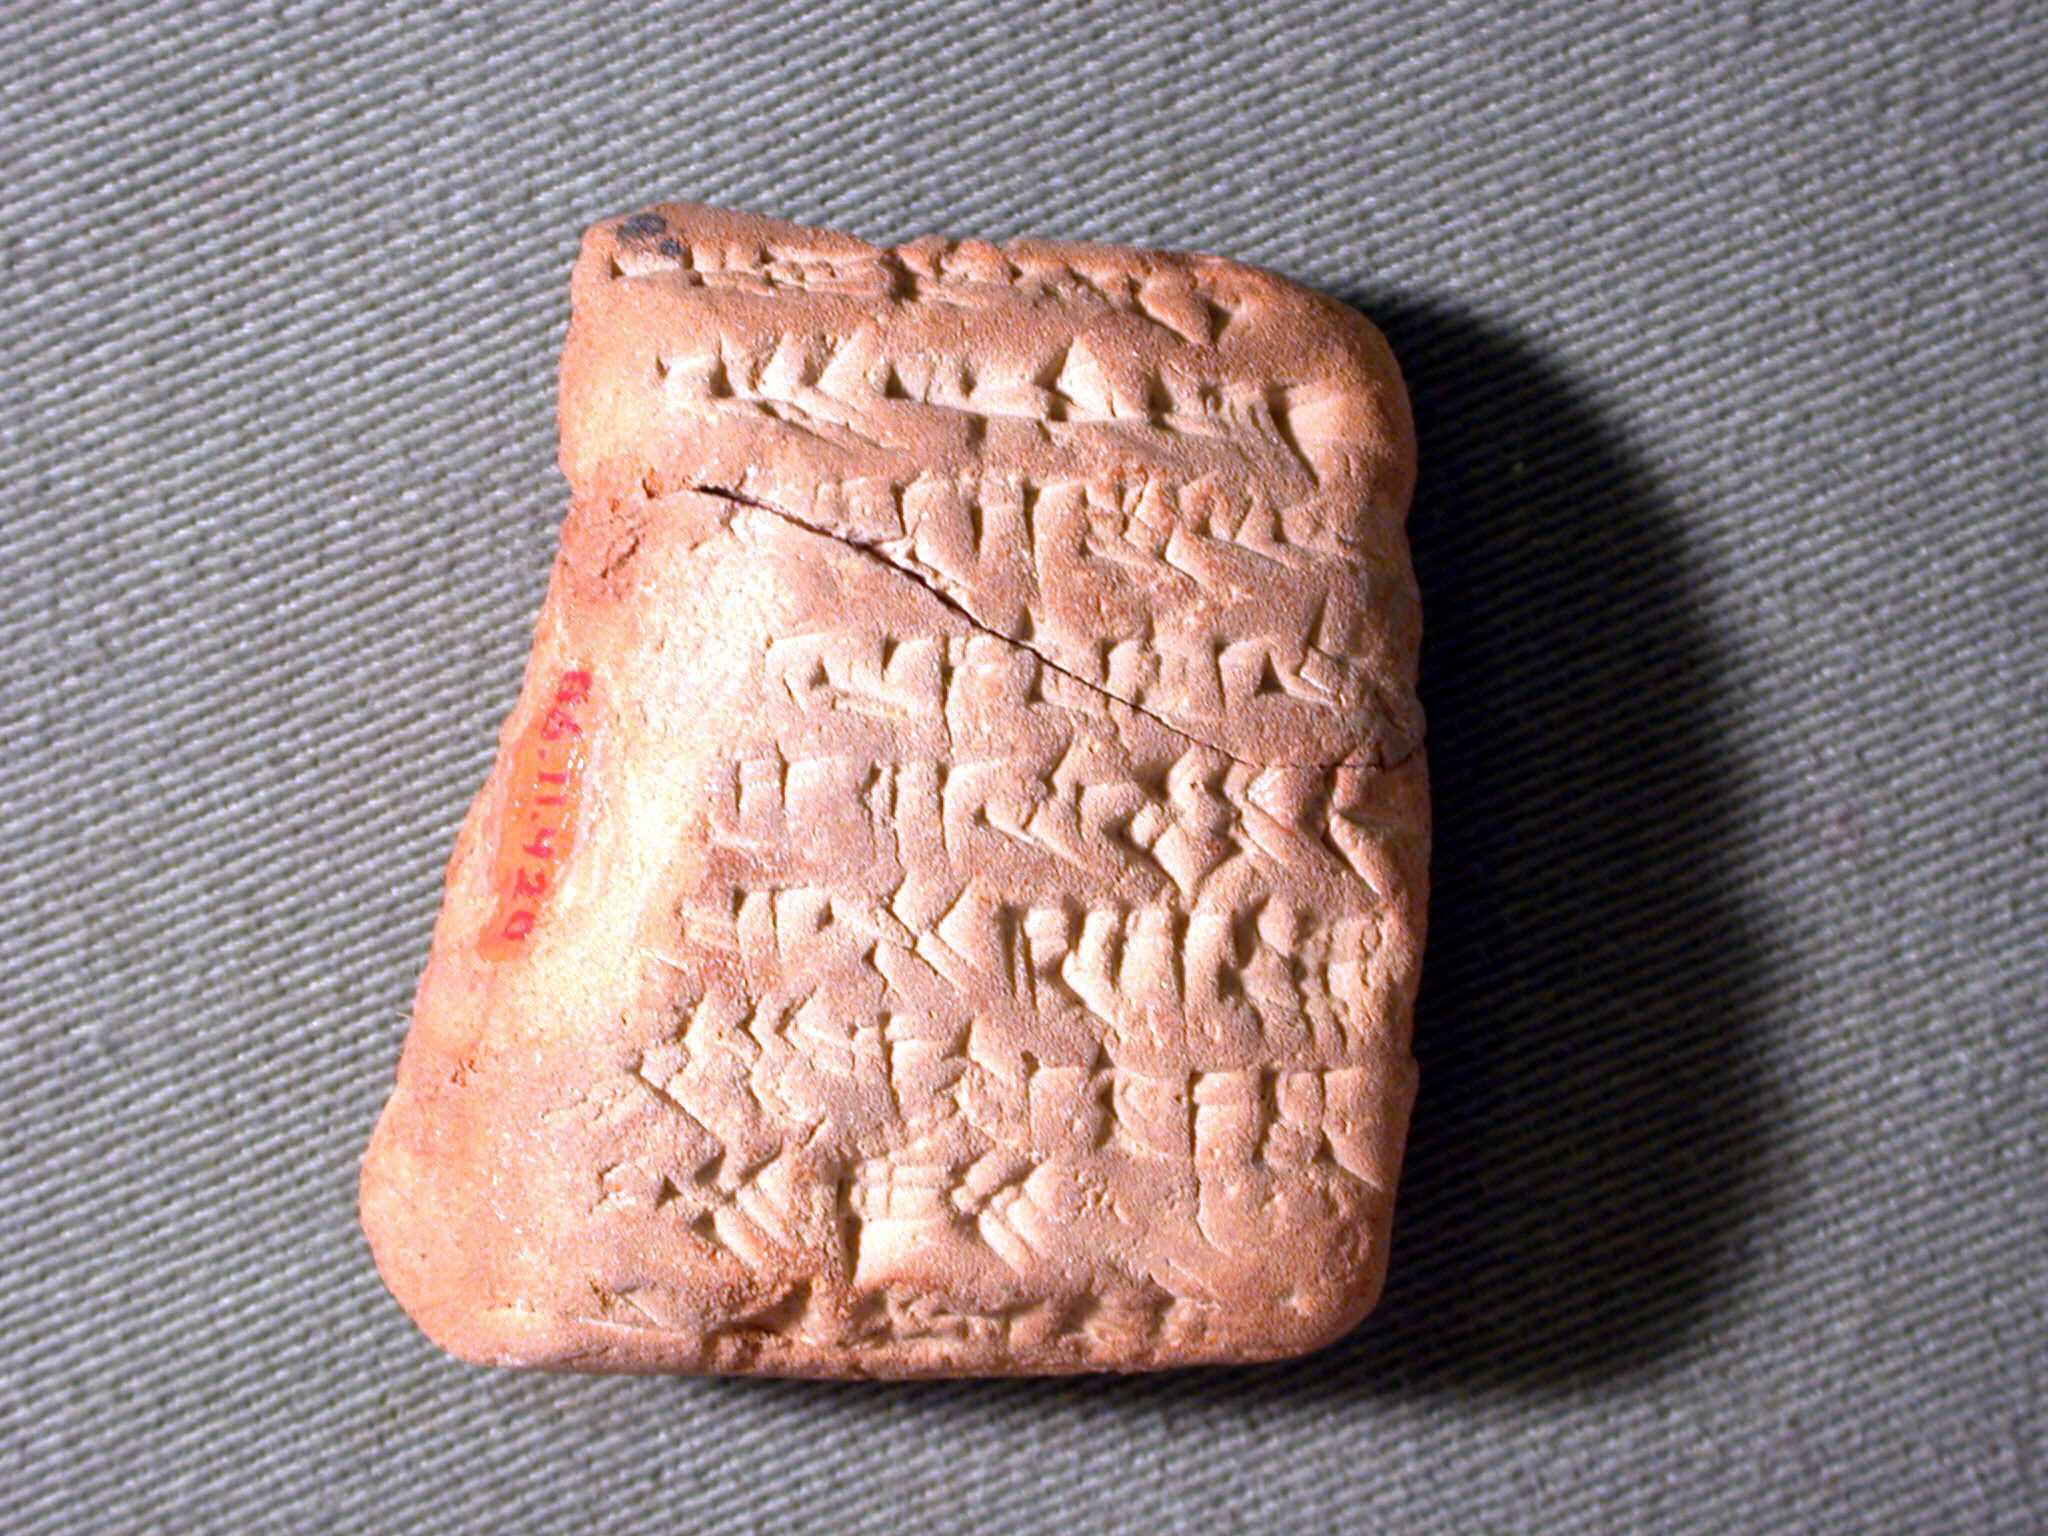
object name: cuneiform tablet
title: Cuneiform tablet: fragment of a contract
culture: babylonian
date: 626-539 BCE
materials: clay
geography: mesopotamia